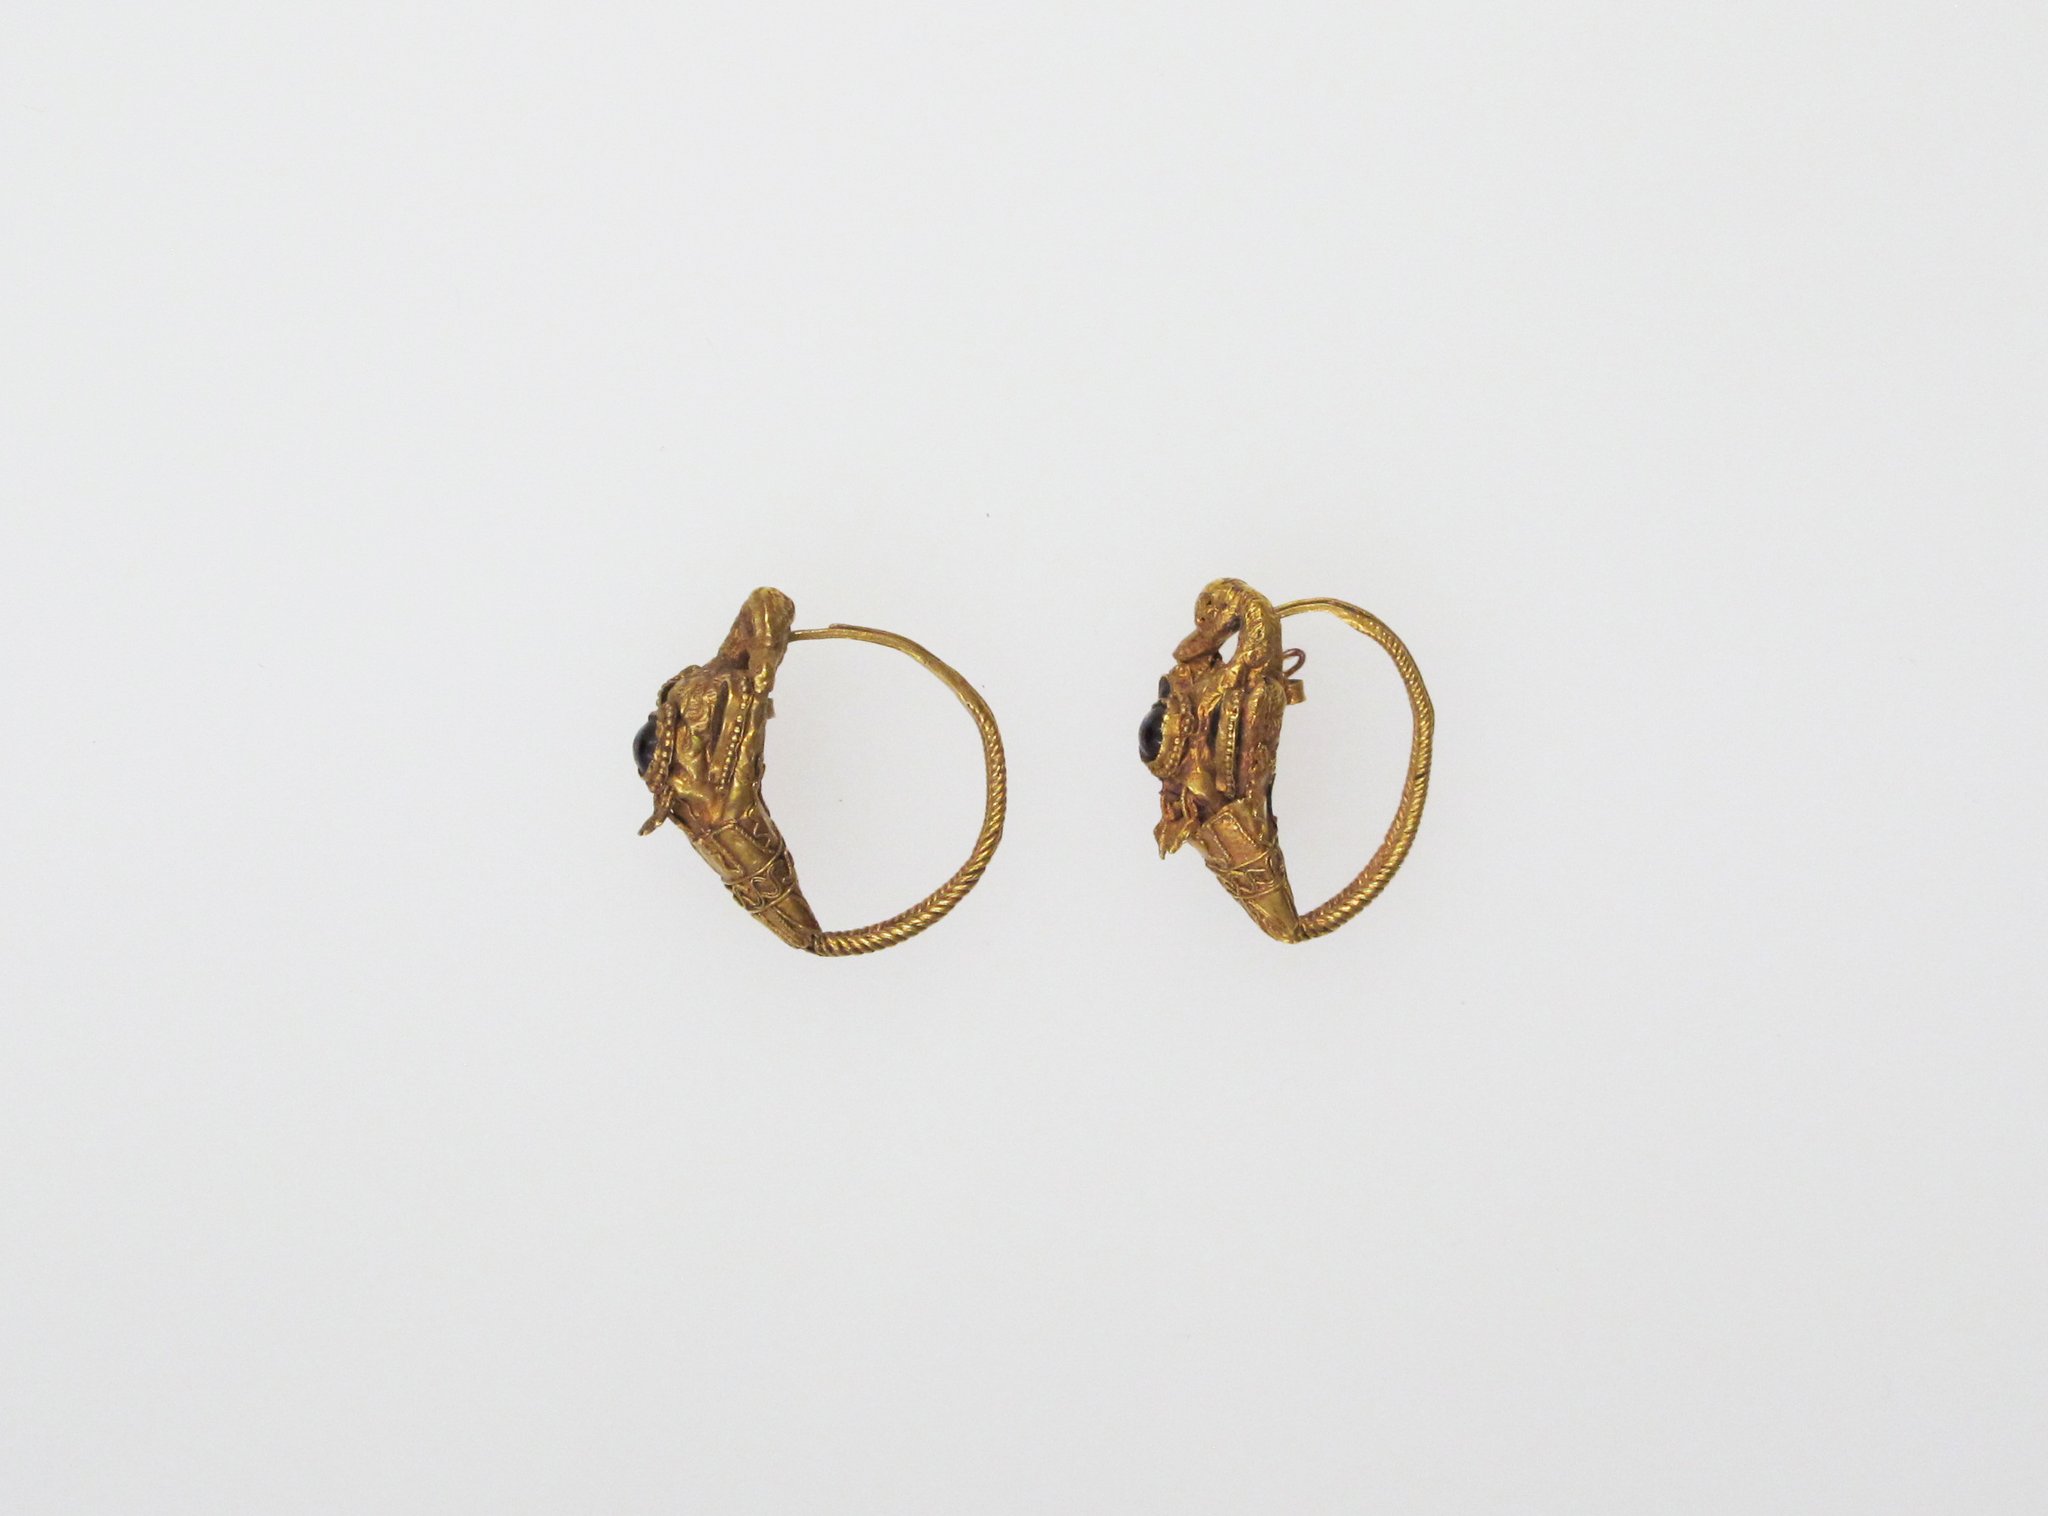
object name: earring with swan or goose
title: Earring with swans or geese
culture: greek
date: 300-201 BCE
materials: gemstone, gold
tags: swans